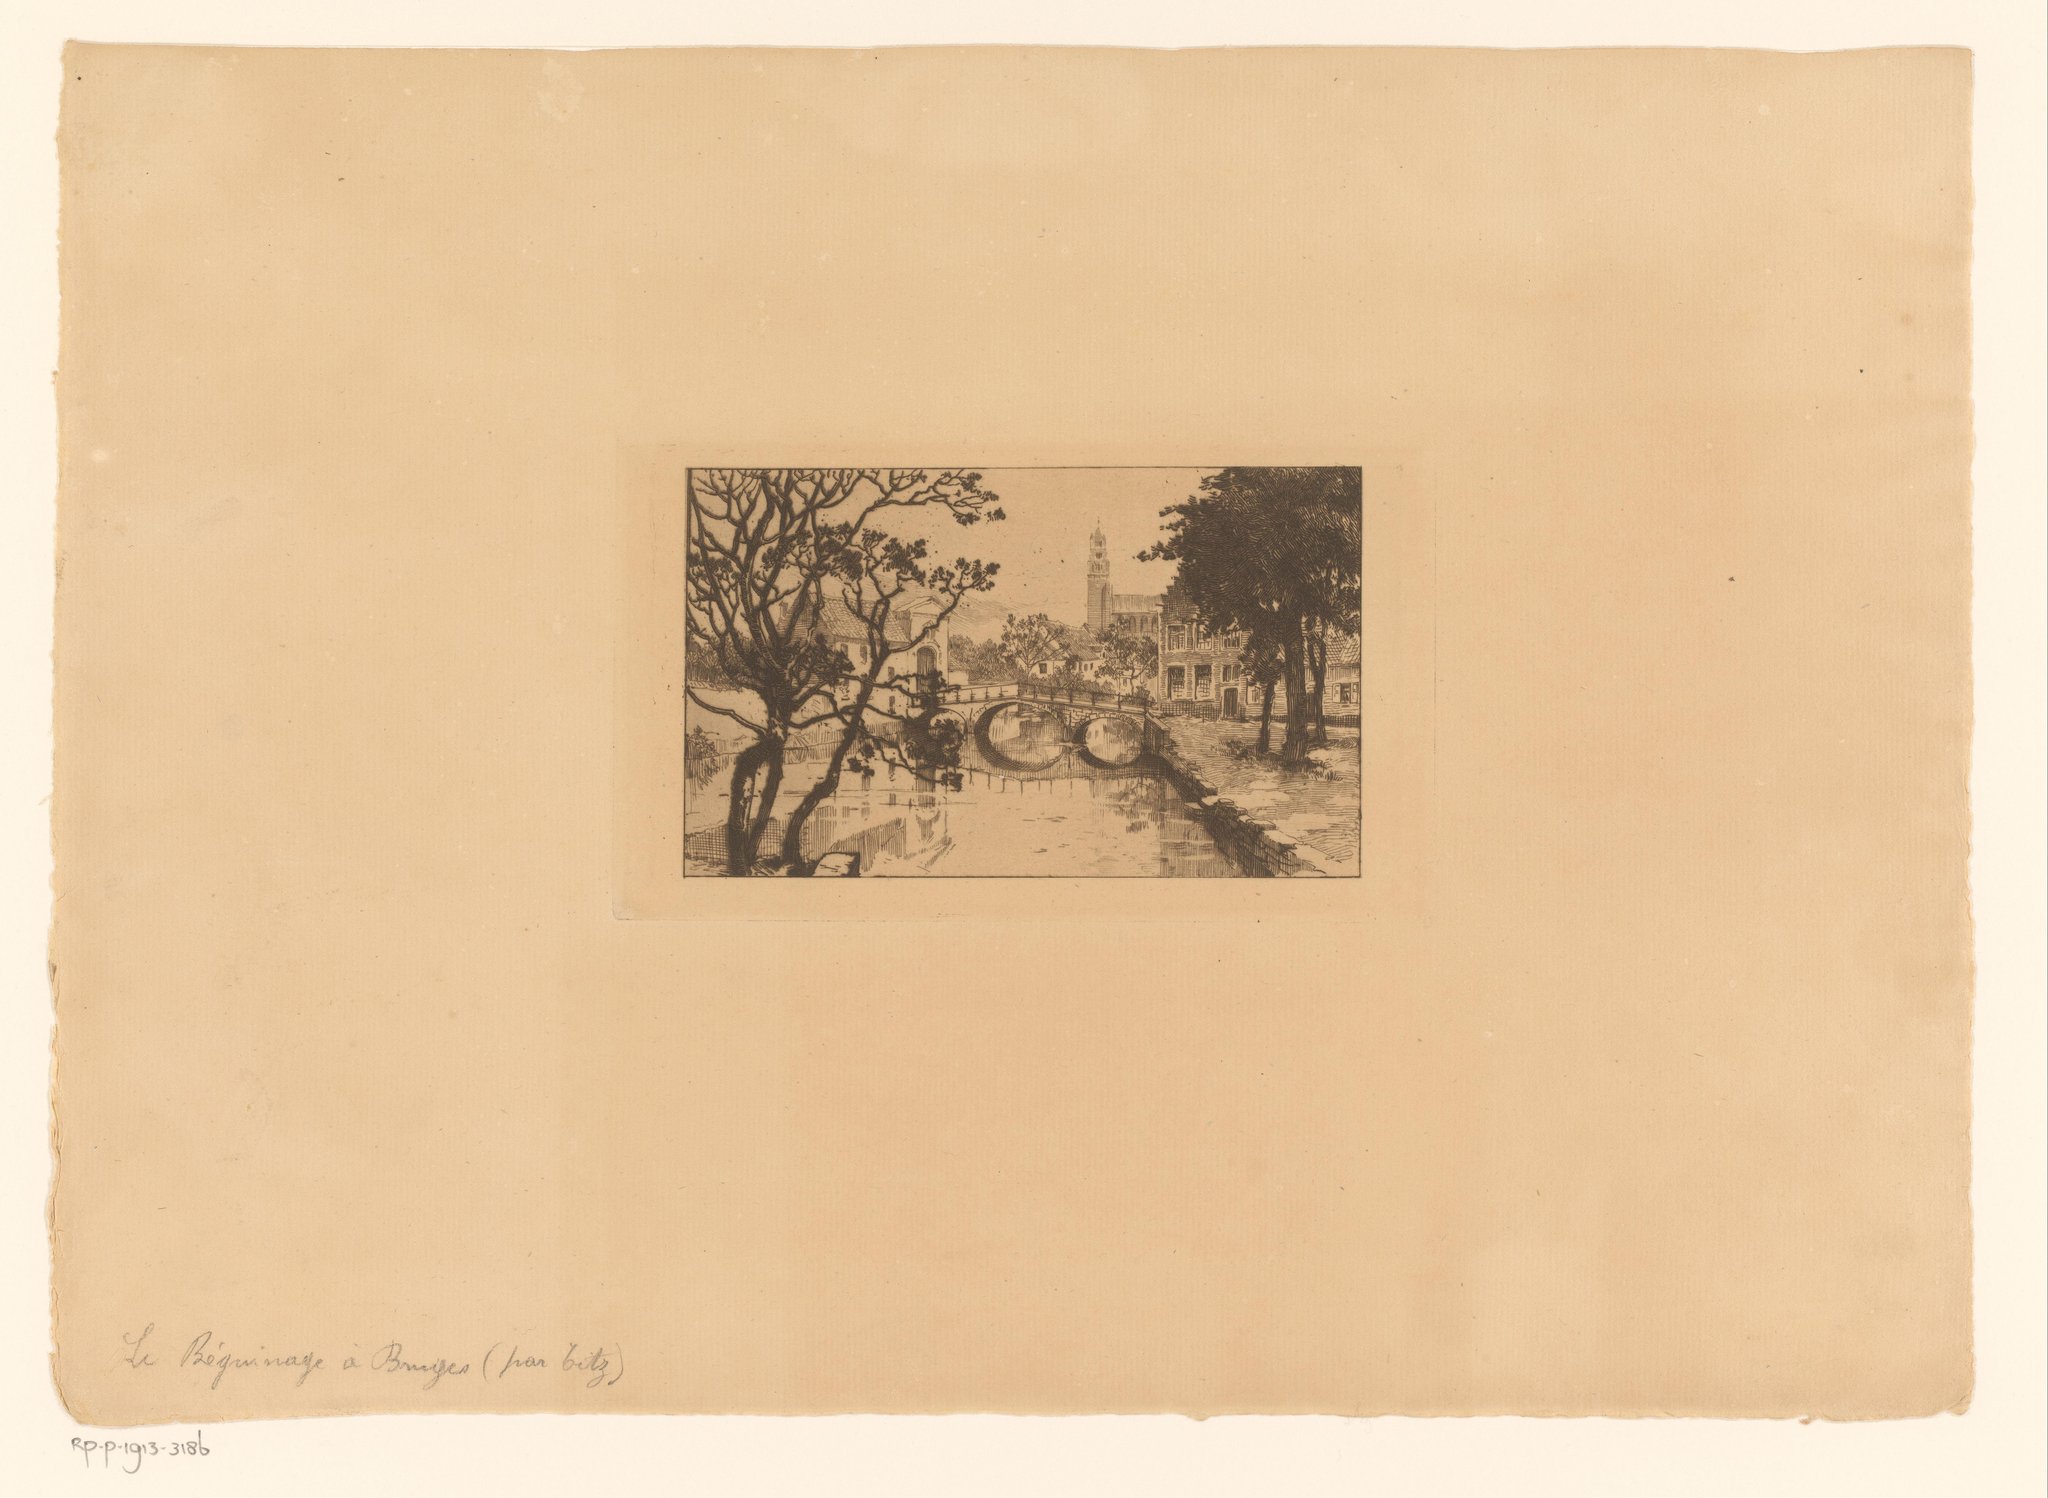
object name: print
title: Begijnhof Ten Wijngaerde en Wijngaardbrug in Brugge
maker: louis titz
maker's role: print maker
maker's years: 1859-1932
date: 1869-1913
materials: paper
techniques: drypoint, etching, intaglio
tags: church (exterior), bridge in city across river, canal, etc.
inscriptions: collector's mark: Lugt 2228